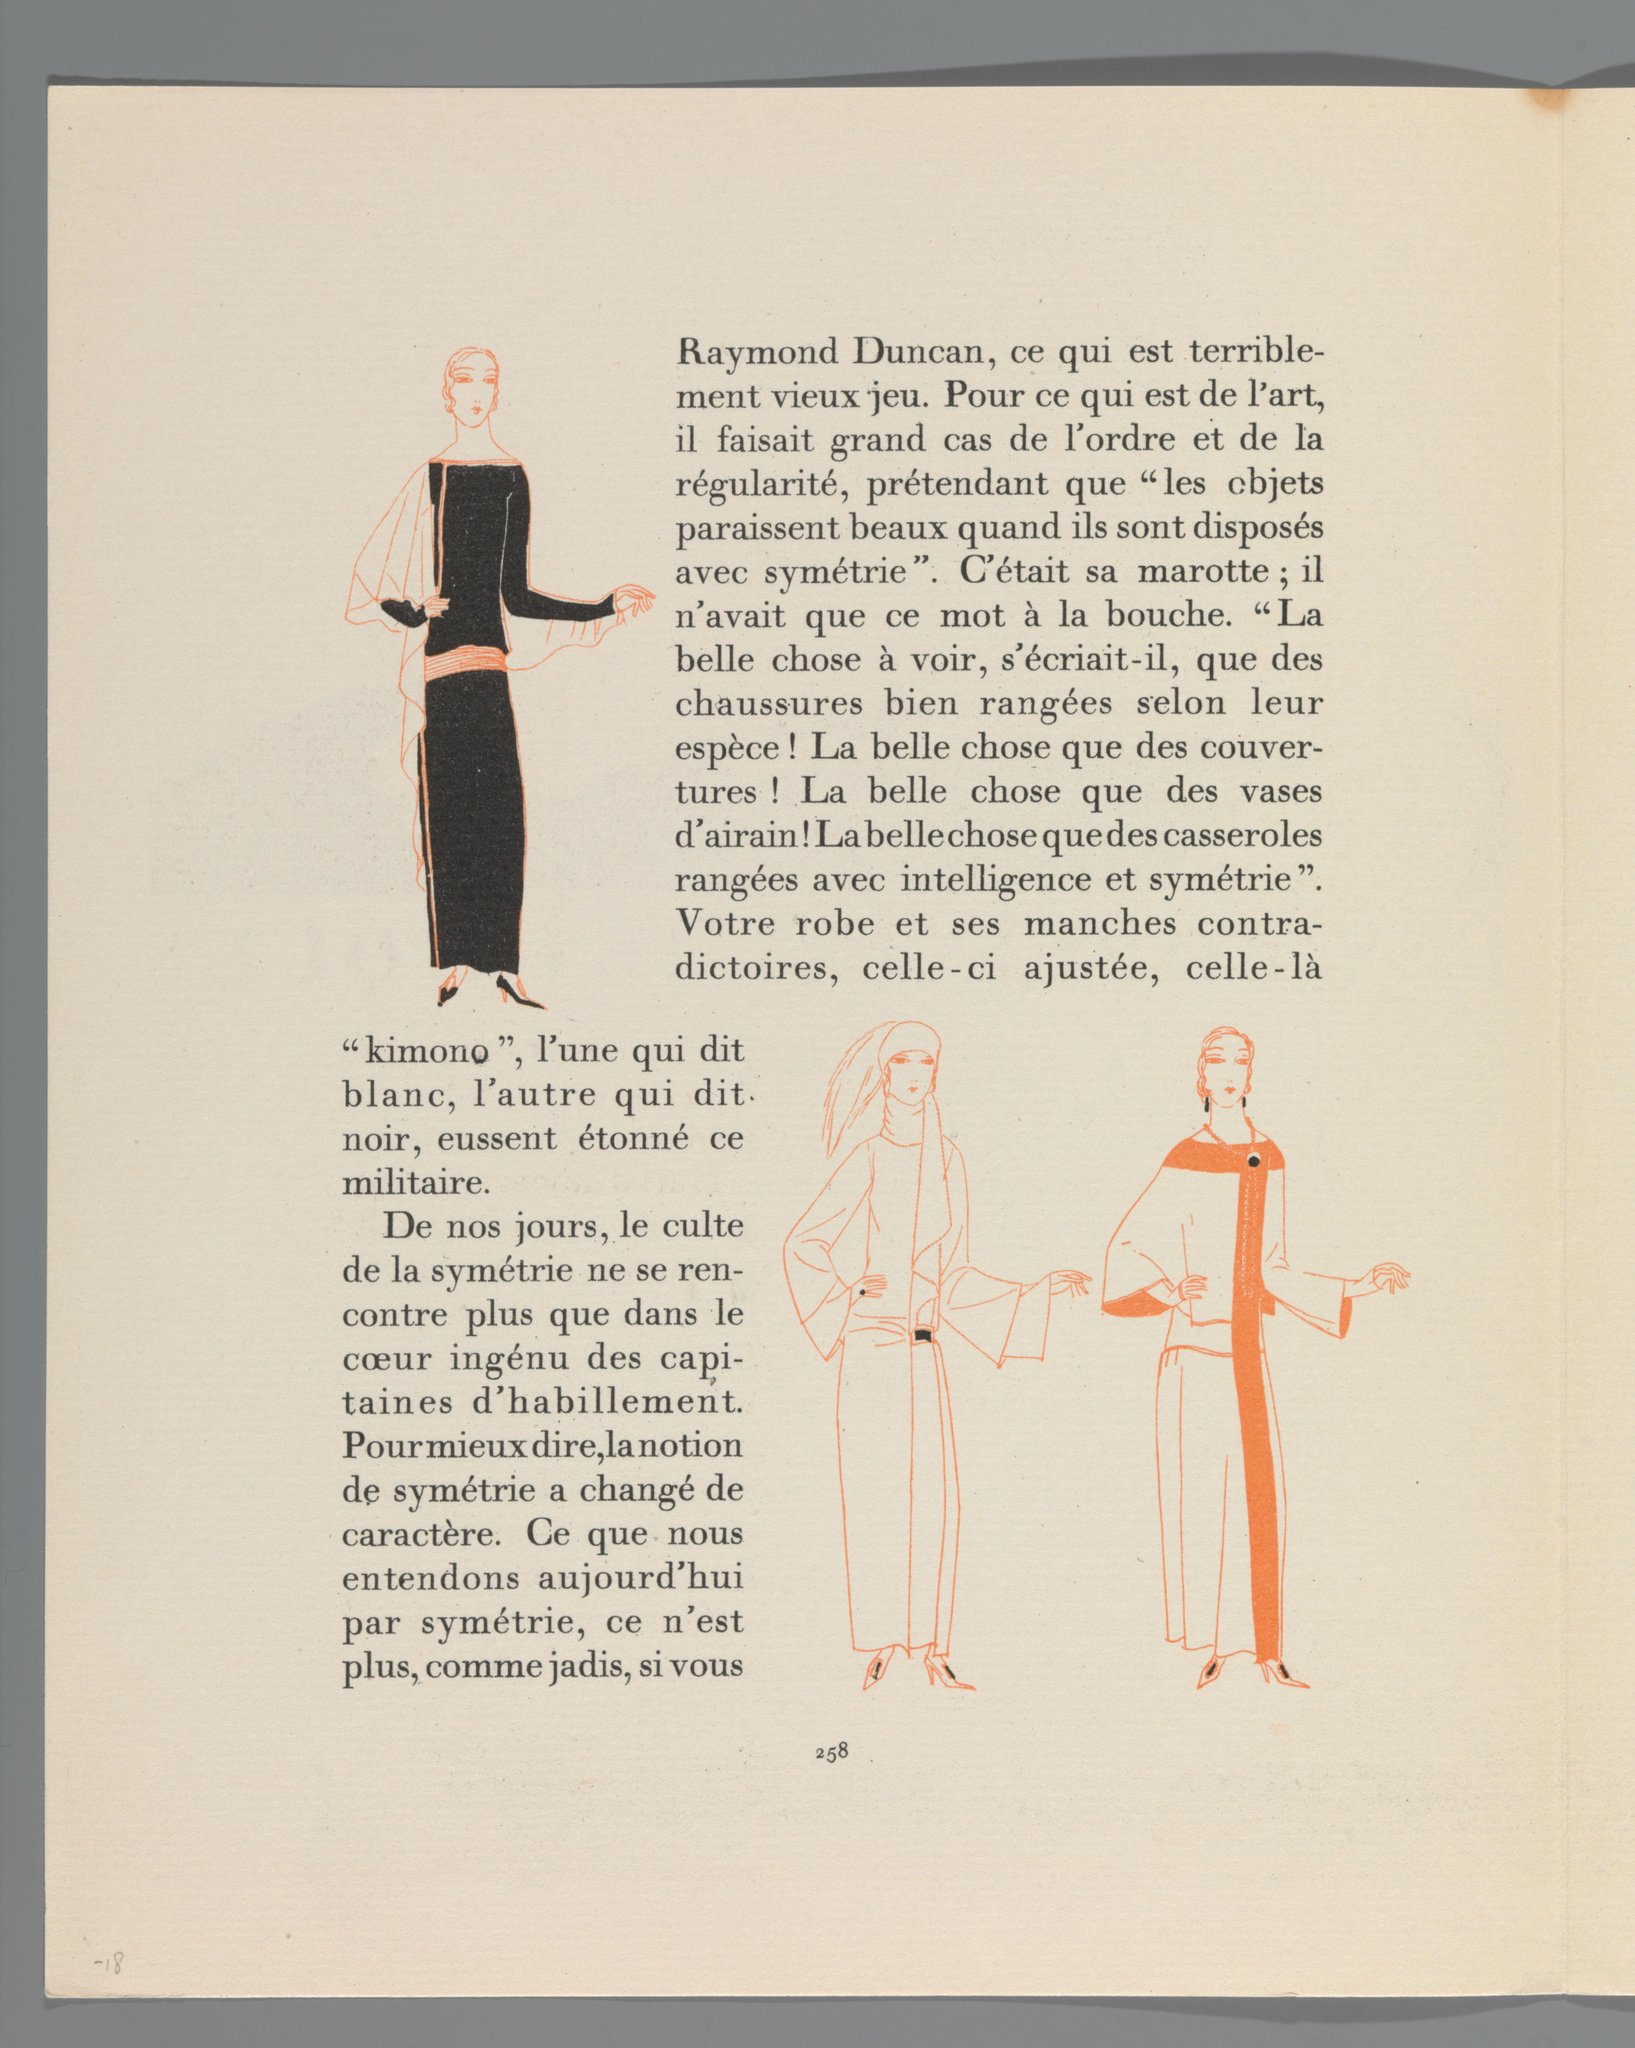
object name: fashion print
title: Gazette du Bon Ton, 1922 - No. 9 : p. 258: les robes assymétriques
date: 1922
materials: paper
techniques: letterpress printing, lithograph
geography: london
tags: fashion plates, dress, gown (+ women's clothes)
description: Pagina 258: les robes assymétriques: tekst en illustraties van drie assymetrische lange japonnen.